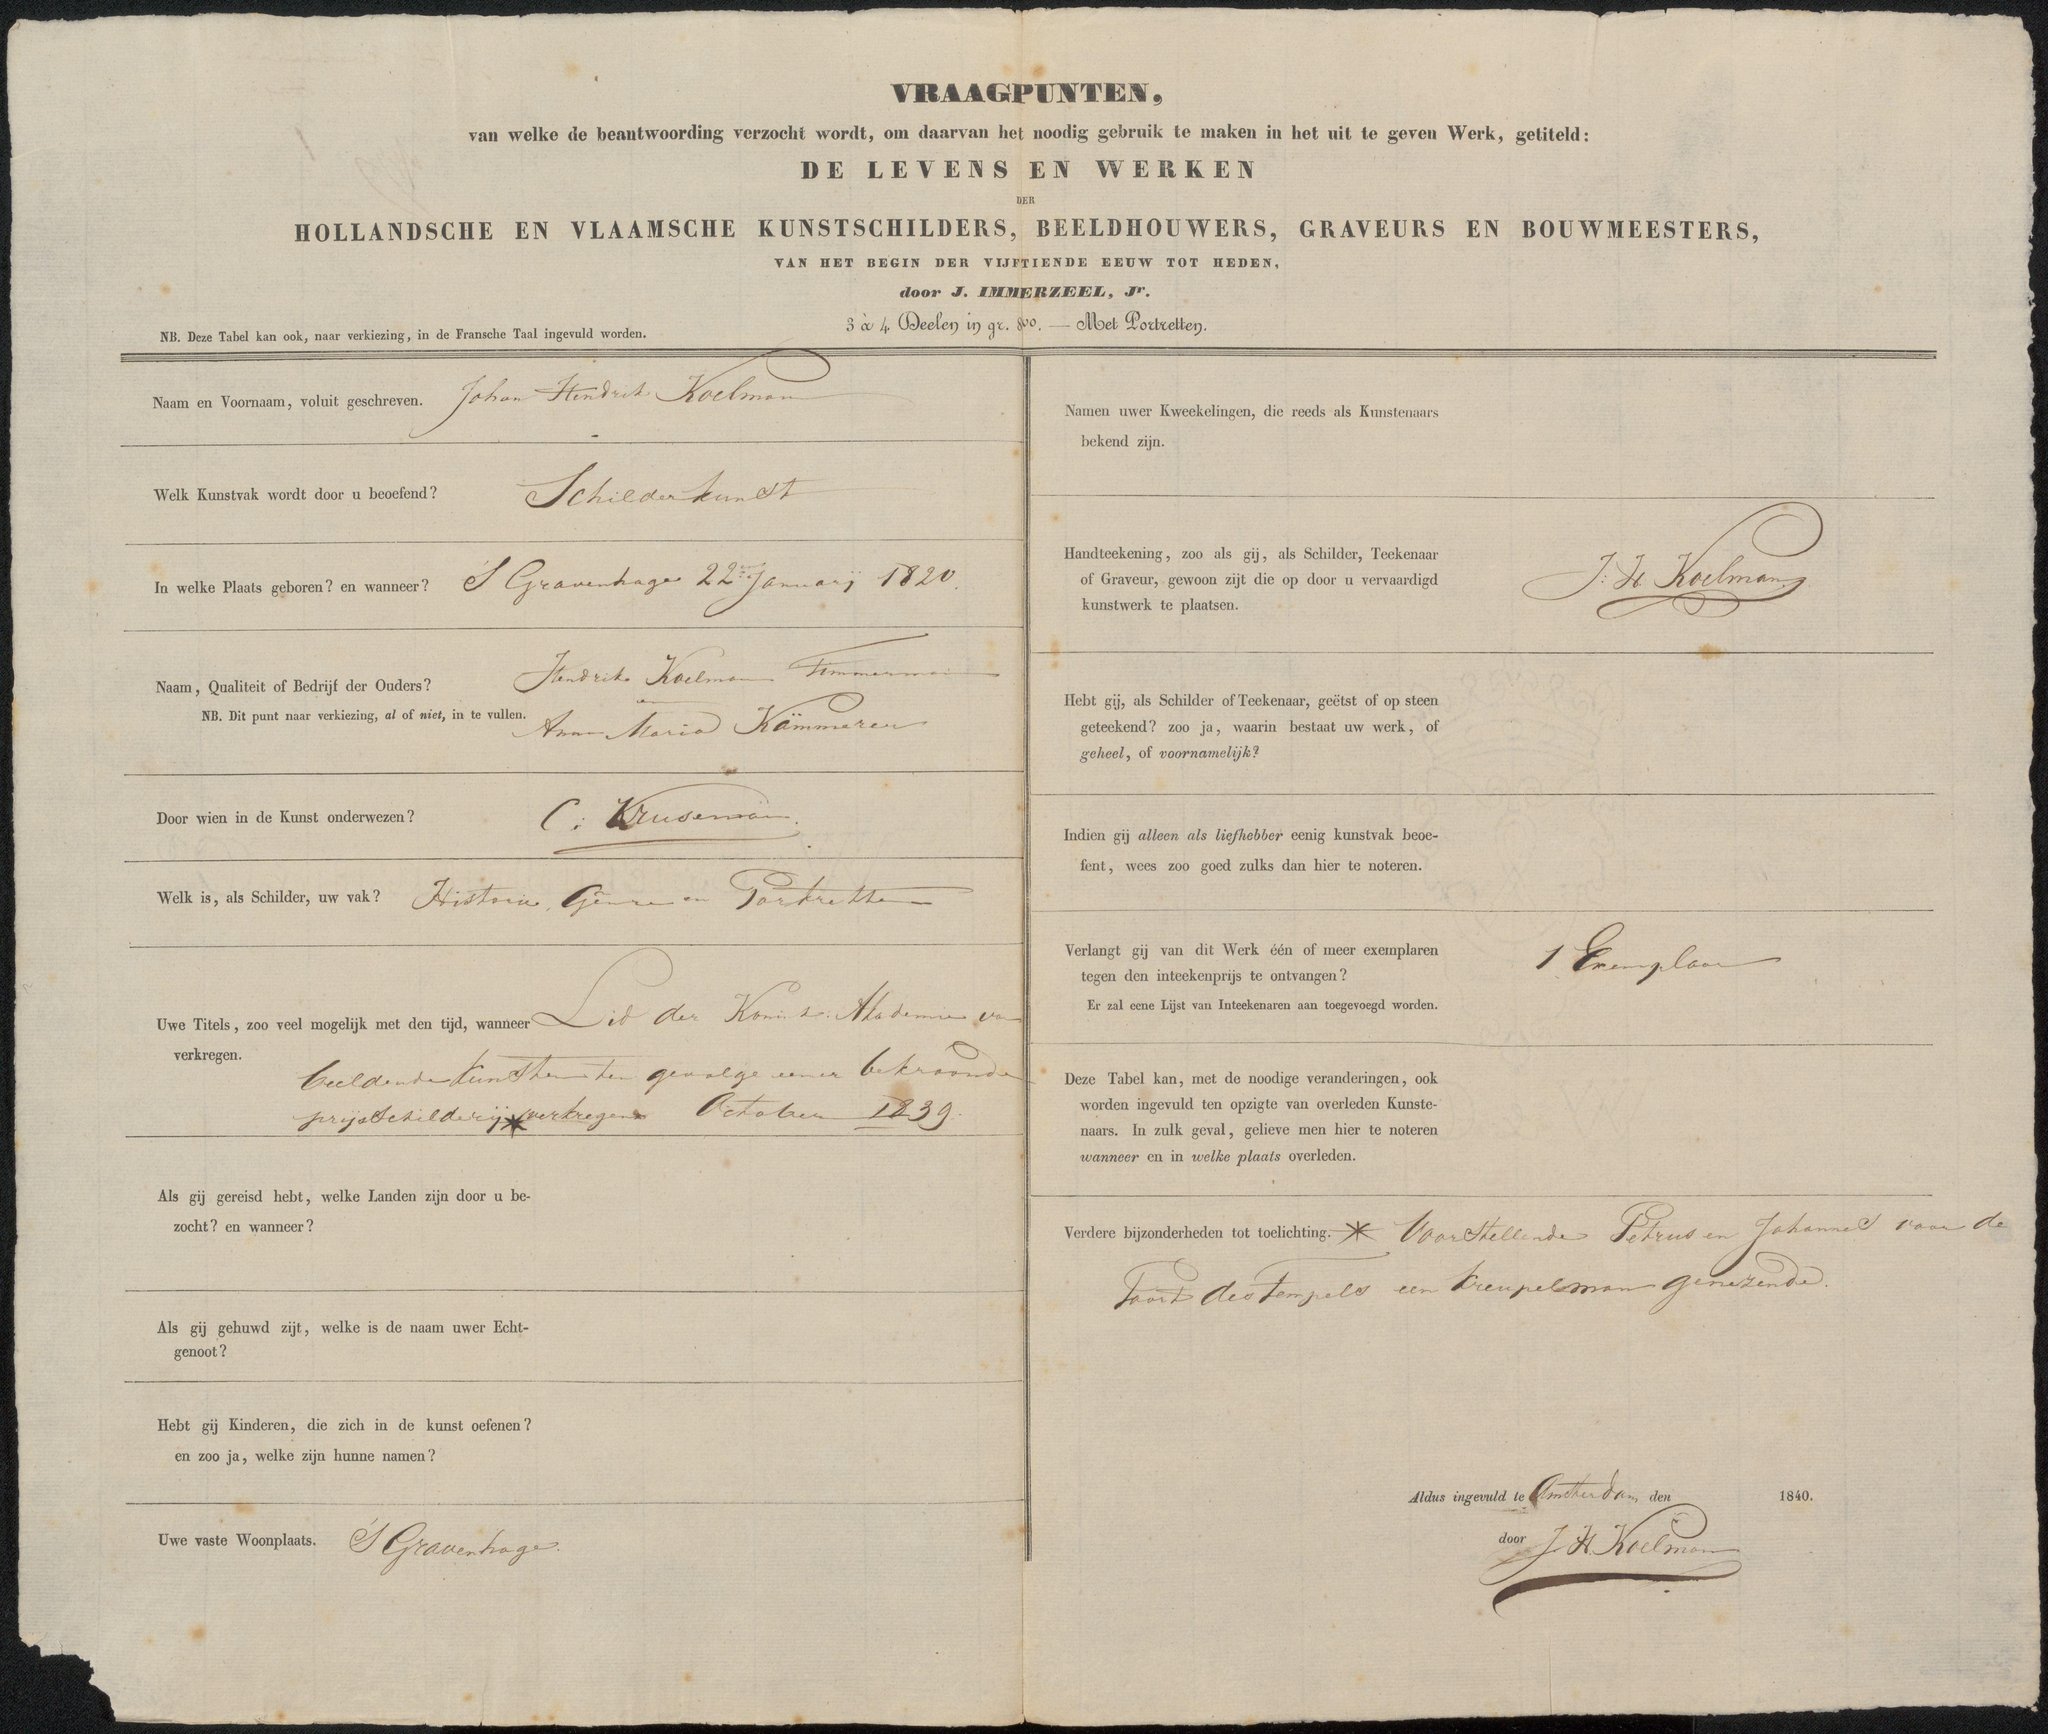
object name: questionnaire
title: Enquêteformulier ingevuld door Johan Hendrik Koelman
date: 1840-1841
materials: ink, paper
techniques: pen, printing, writing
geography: amsterdam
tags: johan hendrik koelman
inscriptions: watermark, inscription: ‘Vraagpunten,/ van welke de beantwoording verzocht wordt, om daarvan het noodig gebruik te maken in het uit te geven Werk, getiteld: De levens en werken/ der Hollandsche en Vlaamsche kunstschilders, beeldhouwers,/ graveurs en bouwmeesters, van het begin der vijftiende eeuw tot heden/ door J. Immerzeel, Jr.’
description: Opgenomen in: Immerzeel, J. Jr., De levens en werken der Hollandsche en Vlaamsche kunstschilders, beeldhouwers, graveurs en bouwmeesters, van het begin der vijftiende eeuw tot heden, Amsterdam: J.C. van Kesteren, 1842-1843.